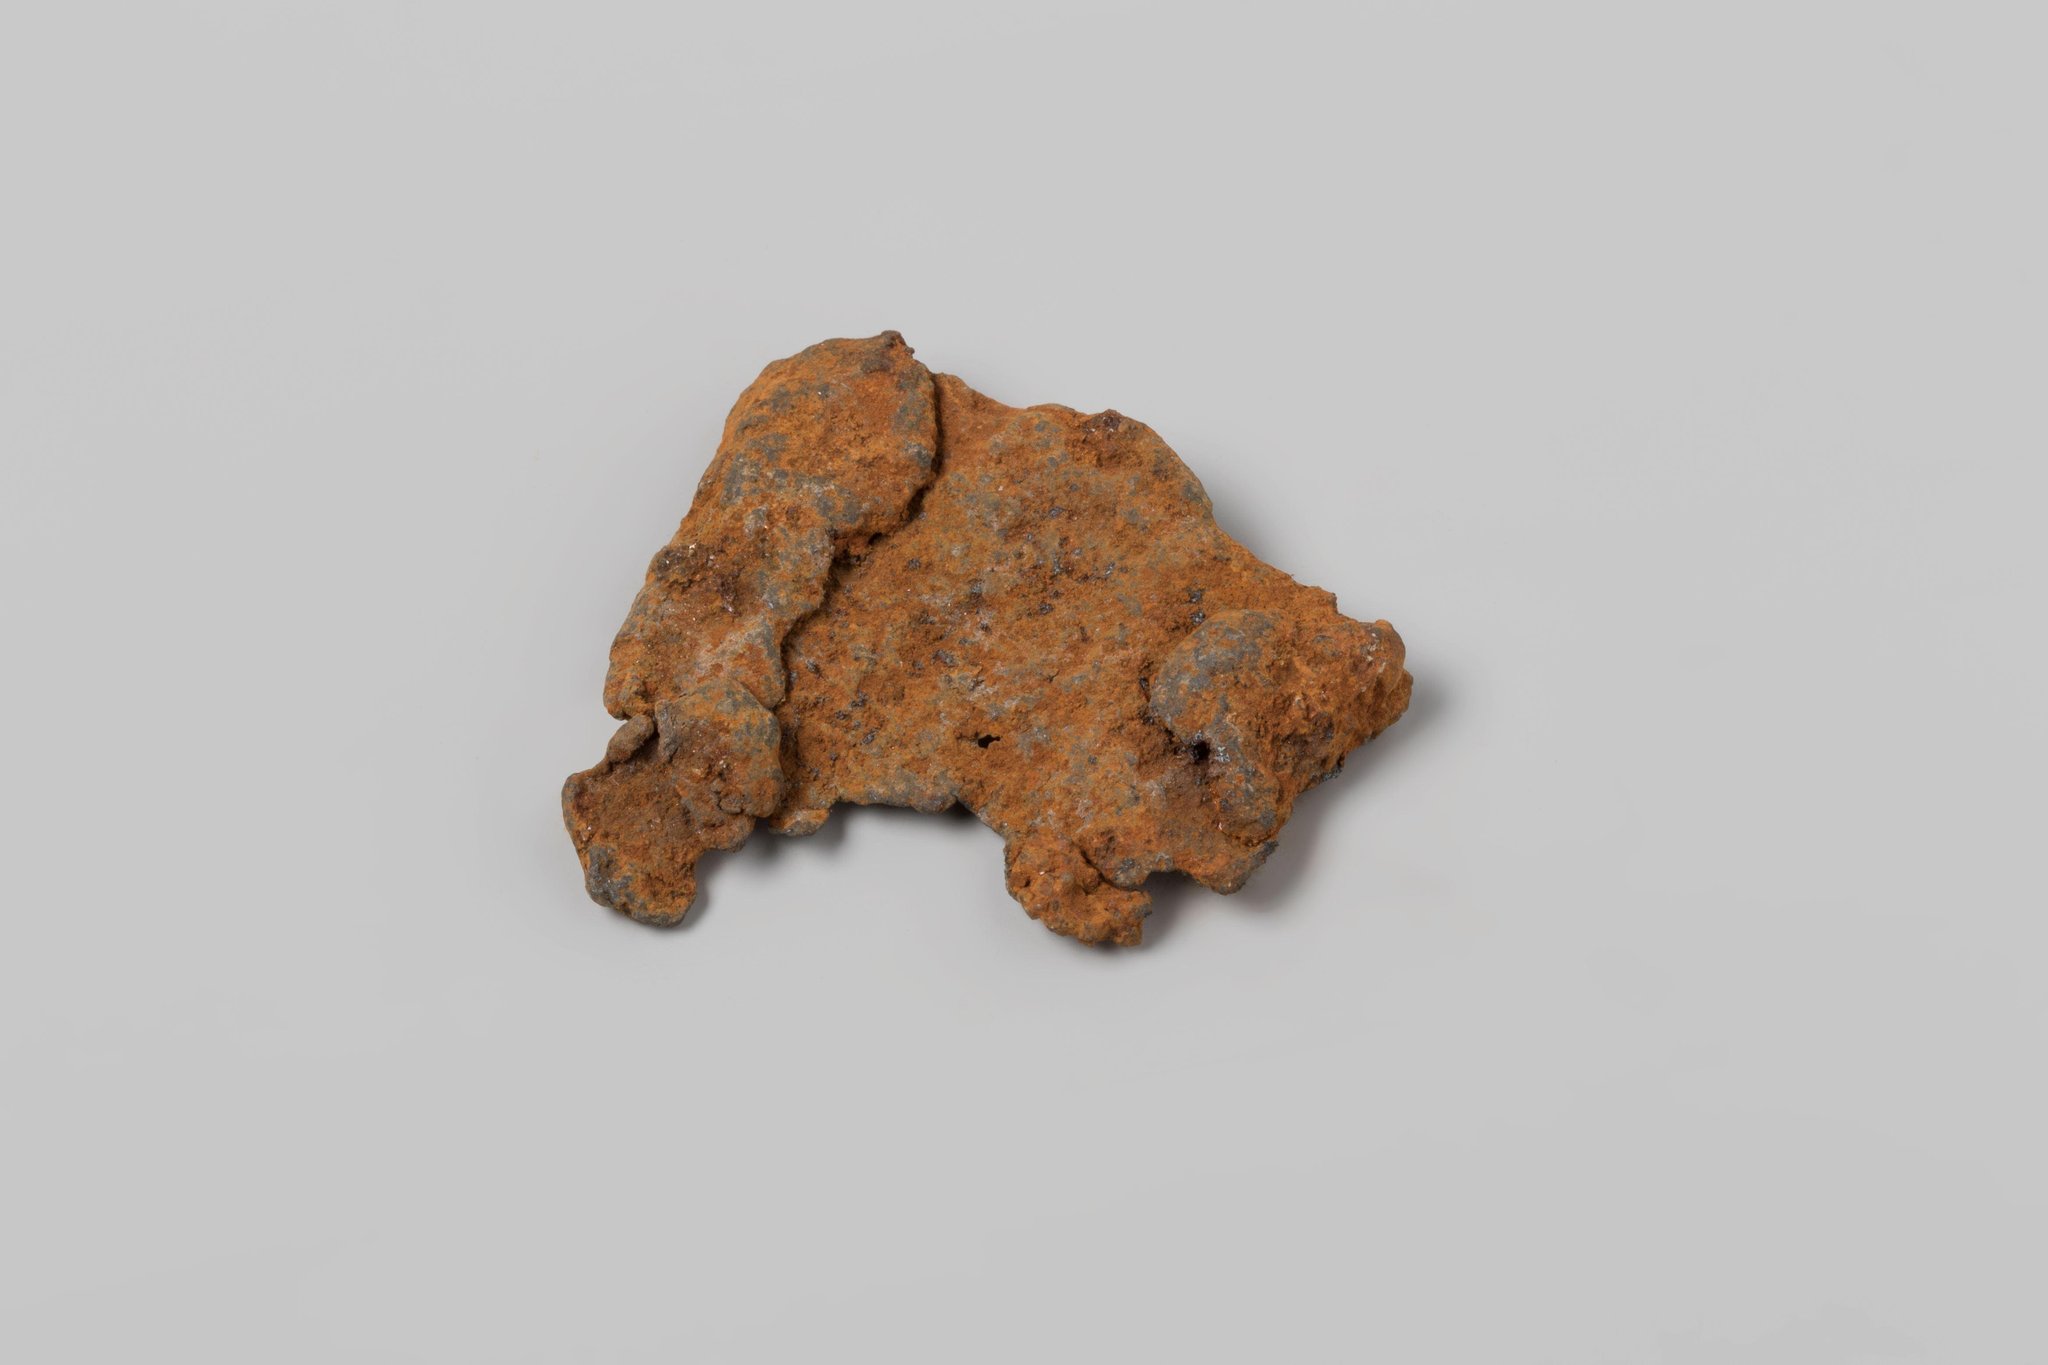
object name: scheepswrakvondst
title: Fragment lood uit het wrak van de Oost-Indiëvaarder Hollandia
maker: Anonymous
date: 1700-1743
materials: lead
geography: netherlands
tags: verenigde oostindische compagnie, hollandia (schip), annet